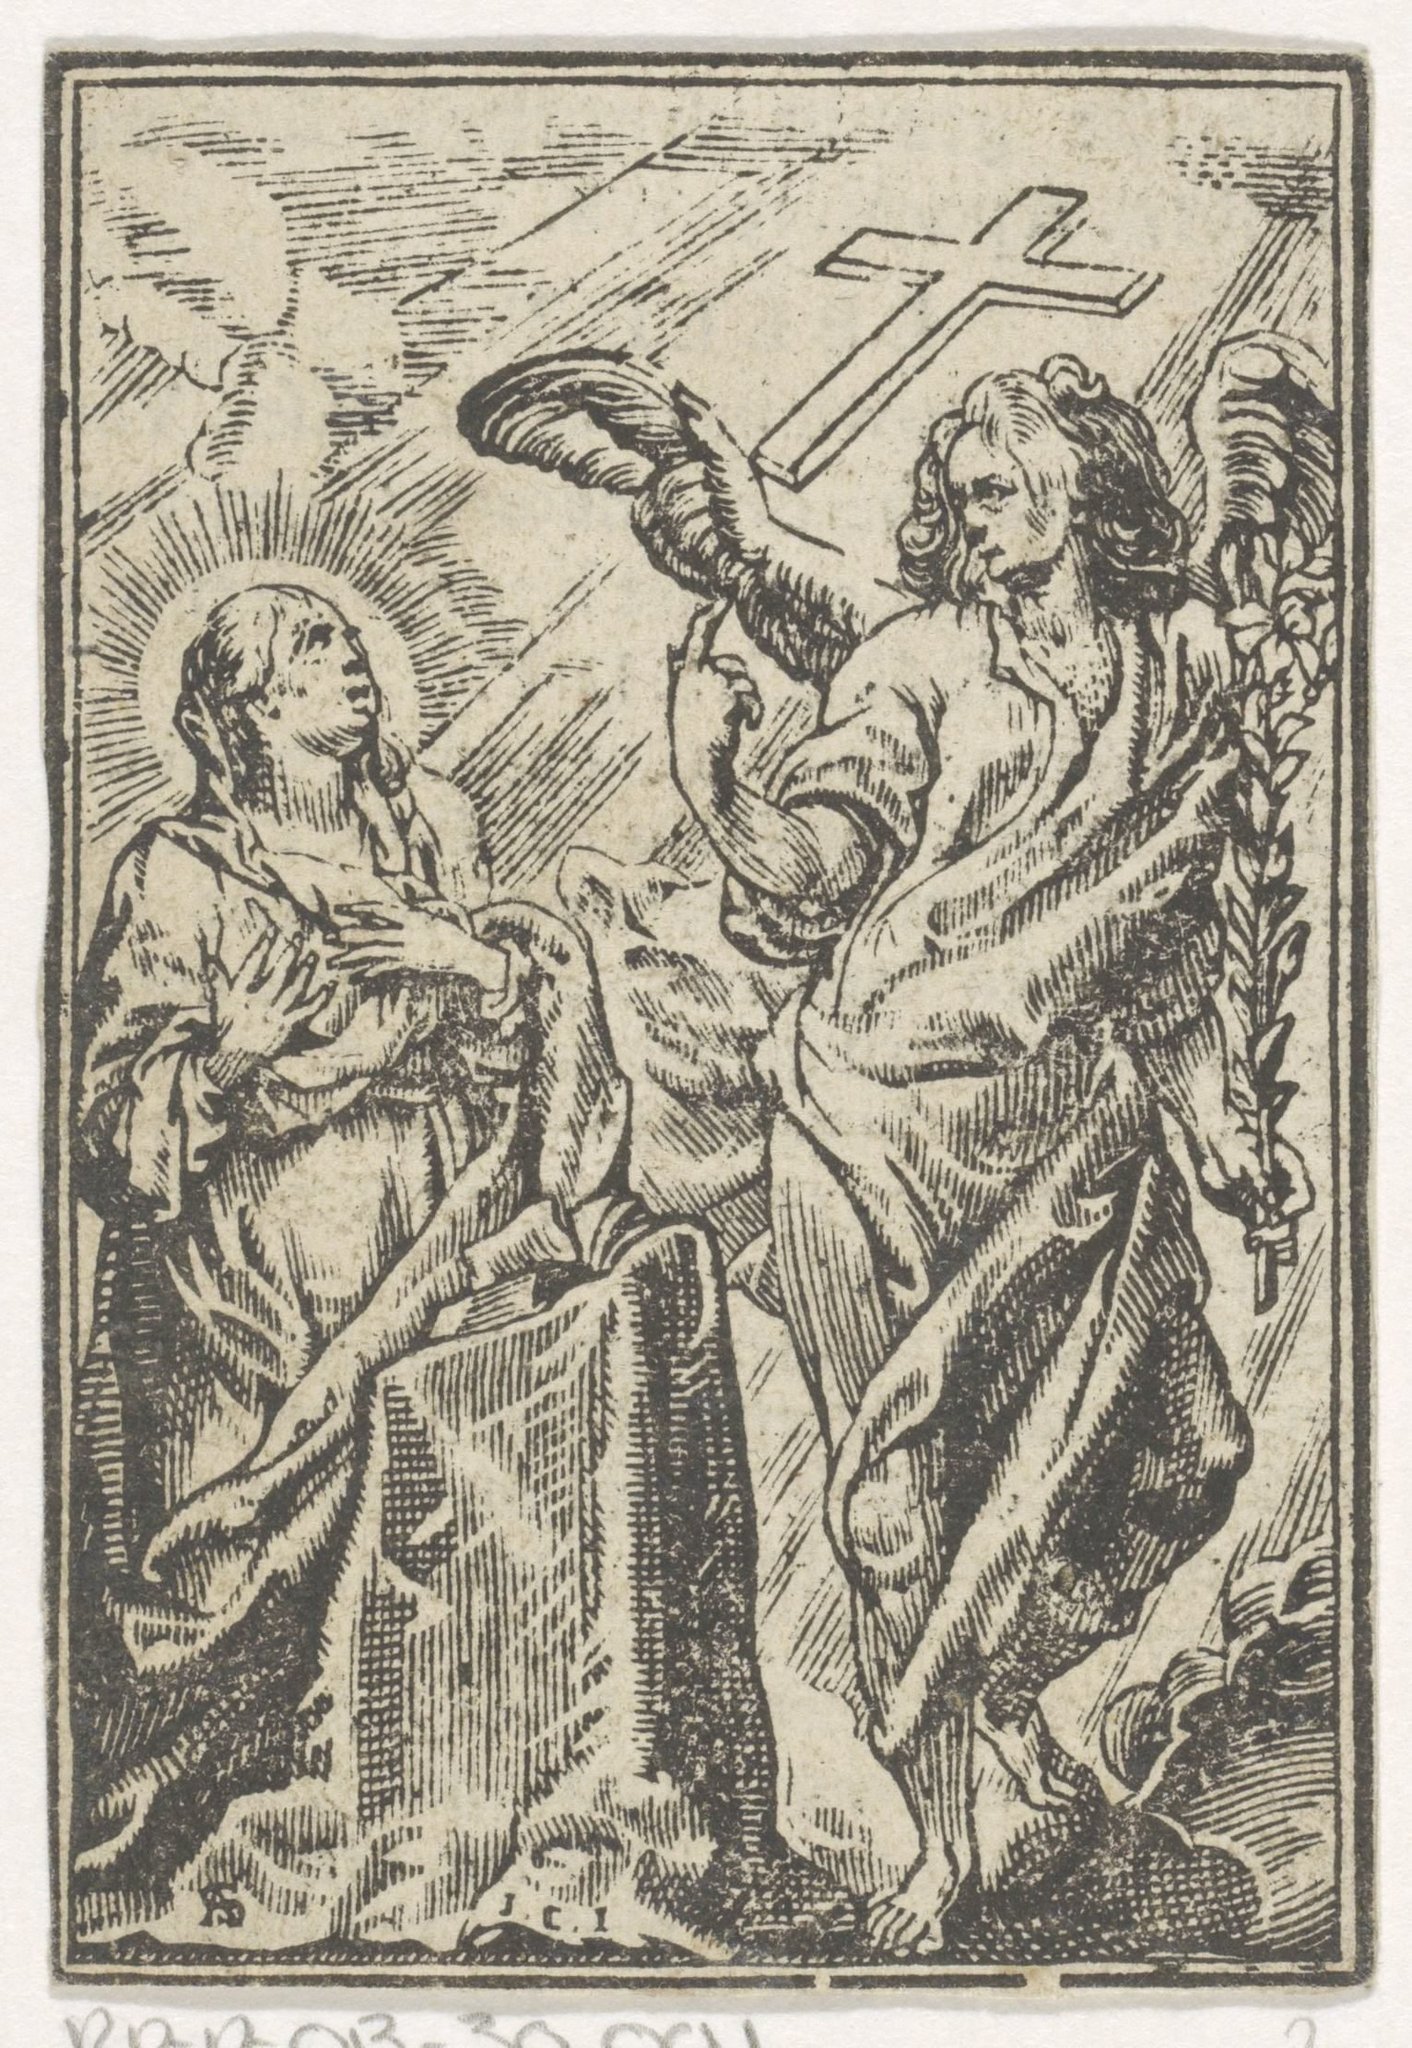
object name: print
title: Annunciatie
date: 1649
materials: paper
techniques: letterpress printing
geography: antwerp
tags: the annunciation: mary, usually reading, is visited by the angel (sometimes a woman overhears the conversation)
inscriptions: collector's mark: Lugt 240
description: De engel Gabriël kondigt aan Maria aan dat ze zwanger zal worden. Maria zit geknield bij een lessenaar, waarop een opengeslagen boek ligt.